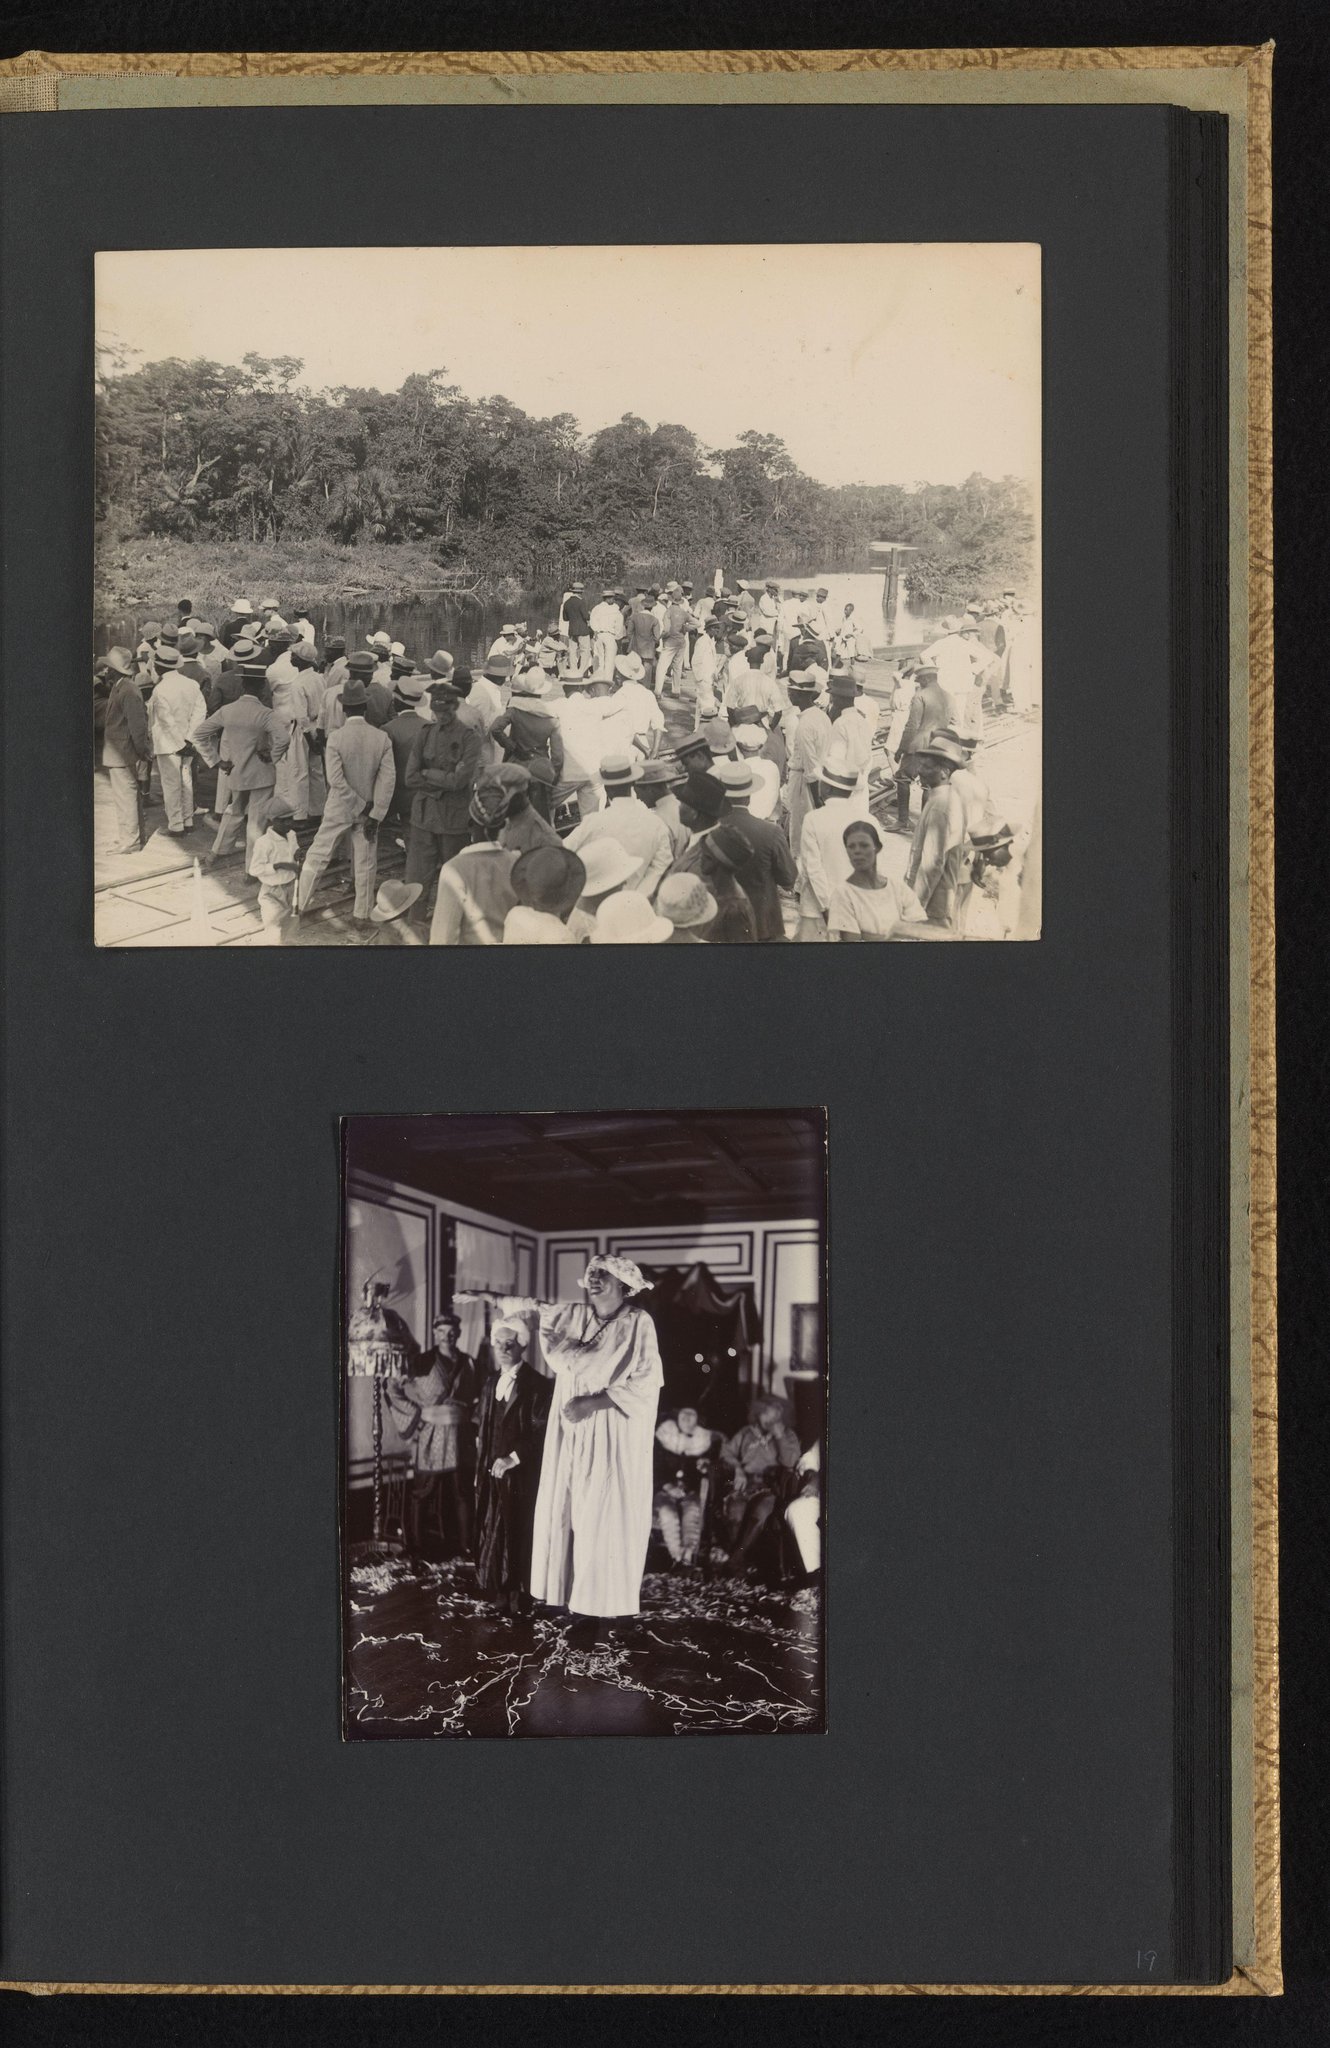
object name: album leaf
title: Menigte en feestavond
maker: Anonymous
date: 1929-1930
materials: paper, photographic support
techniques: gelatin silver print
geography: suriname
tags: private festivities, merry company (+ costume party ~ festive activities), folk costume, regional costume, pier, quay, wharf, suriname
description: Albumblad met twee foto's: een menigte verzameld op een steiger aan de waterkant en een optreden van iemand verkleed in koto op een feestavond. Onderdeel van het album van de familie Guilonard over de bauxietwinning in Moengo en Albina in Suriname in de jaren 1929-1930.